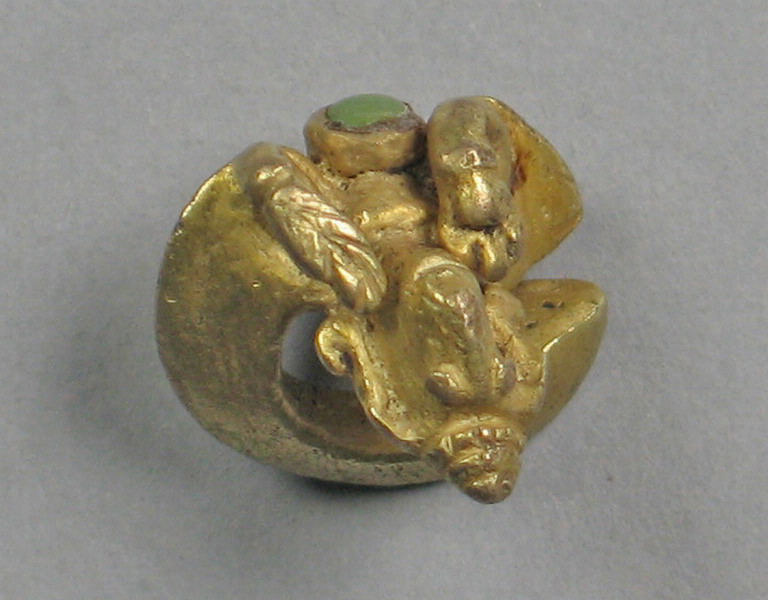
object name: ear ornament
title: Ear ornament , Garuda, Meru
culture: indonesian, central java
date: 701-1200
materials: gold